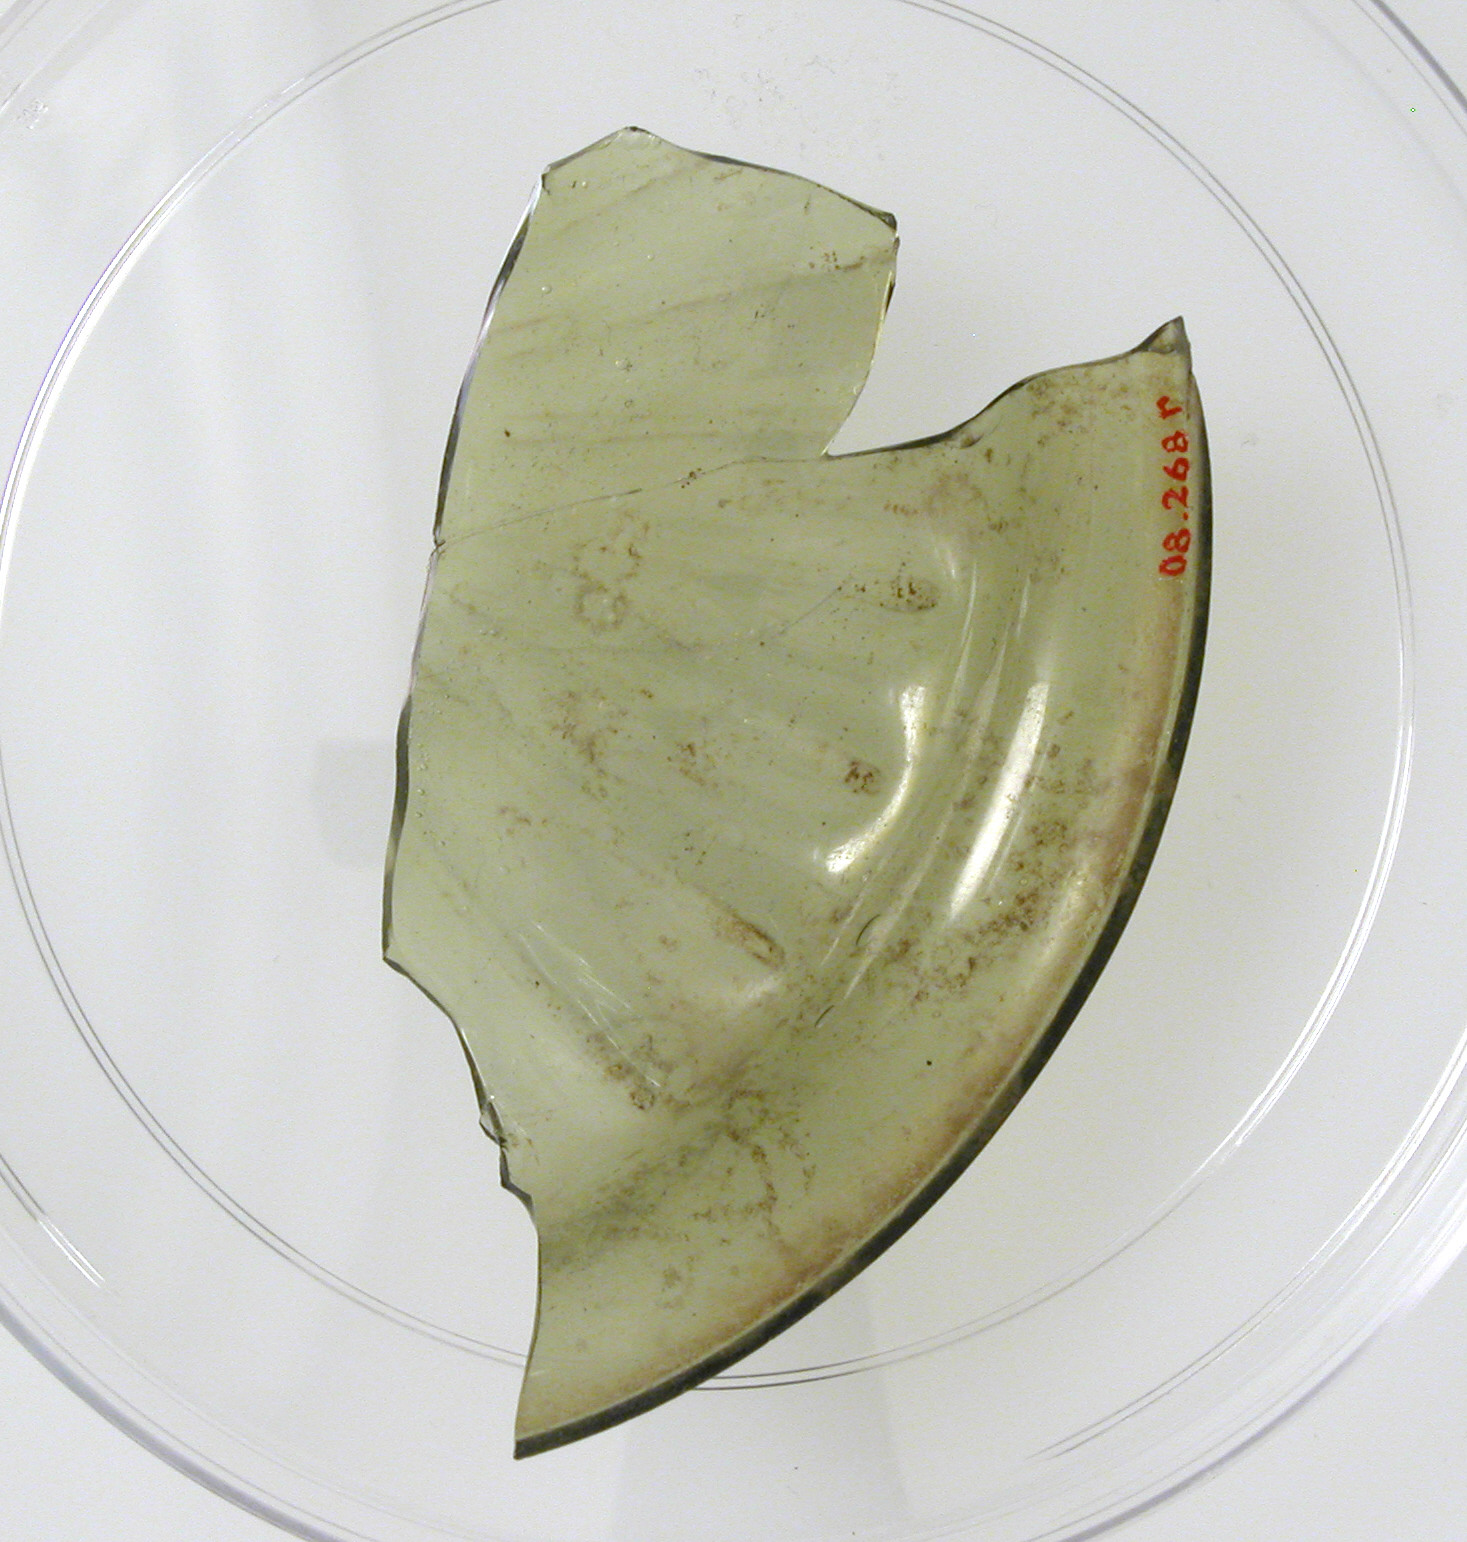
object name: fragment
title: Fragment of Bowl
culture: coptic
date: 301-433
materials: glass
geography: egypt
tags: bowls